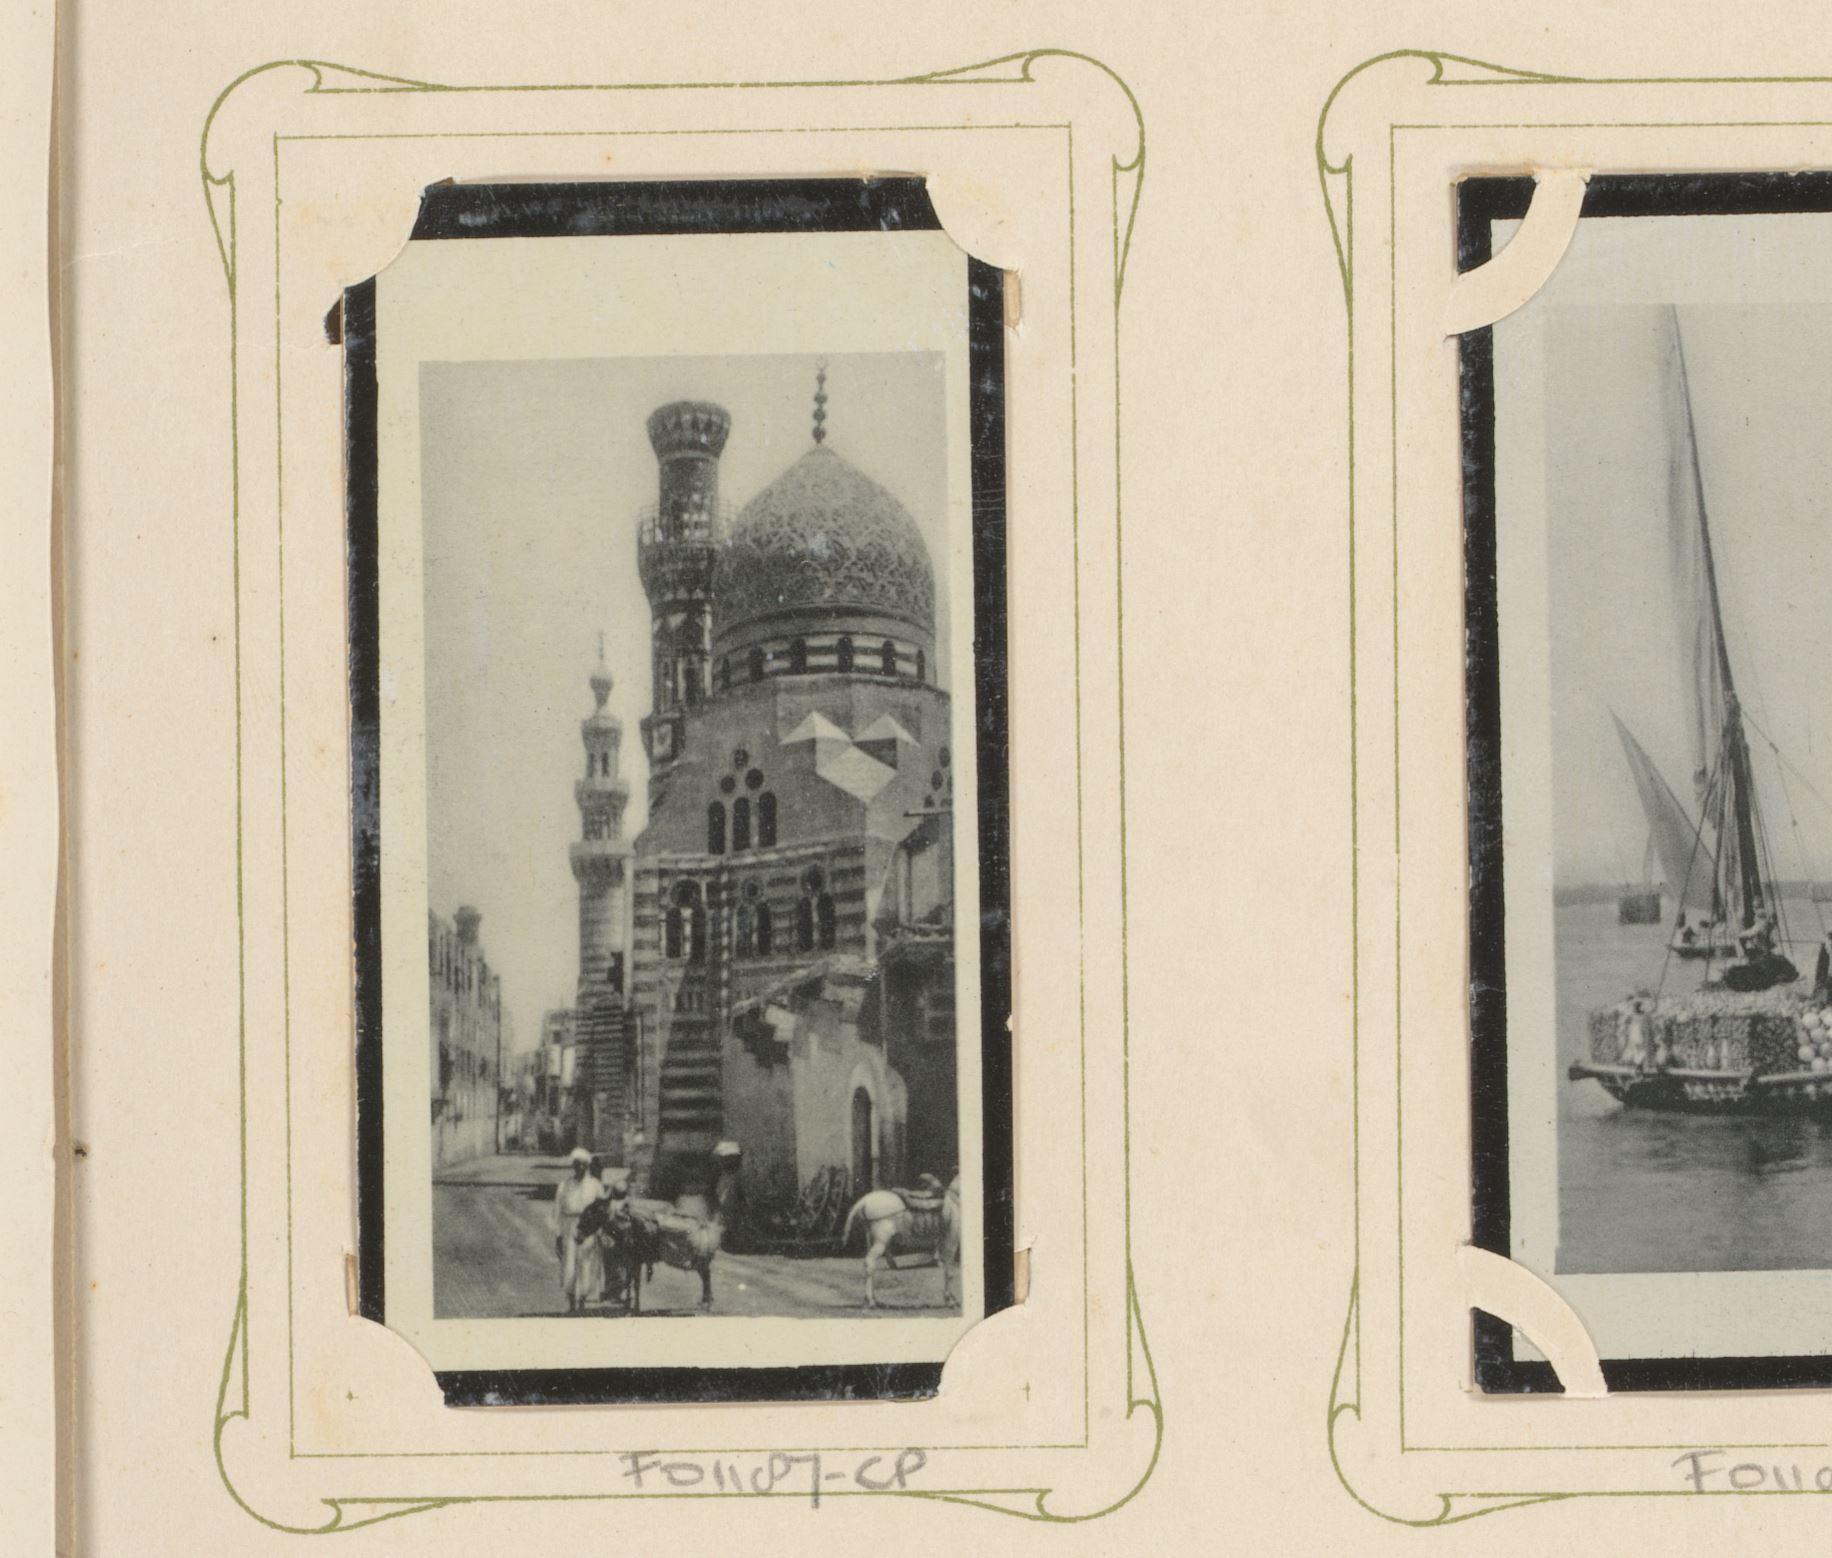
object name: album leaf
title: Gezicht op een straat in Caïro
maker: Anonymous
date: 1905-1906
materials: paper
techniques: photograph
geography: cairo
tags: street, prospect of city, town panorama, silhouette of city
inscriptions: inscription: ‘No. 1./ Straat te Caïro.’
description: Deze prent maakt deel uit van een album.